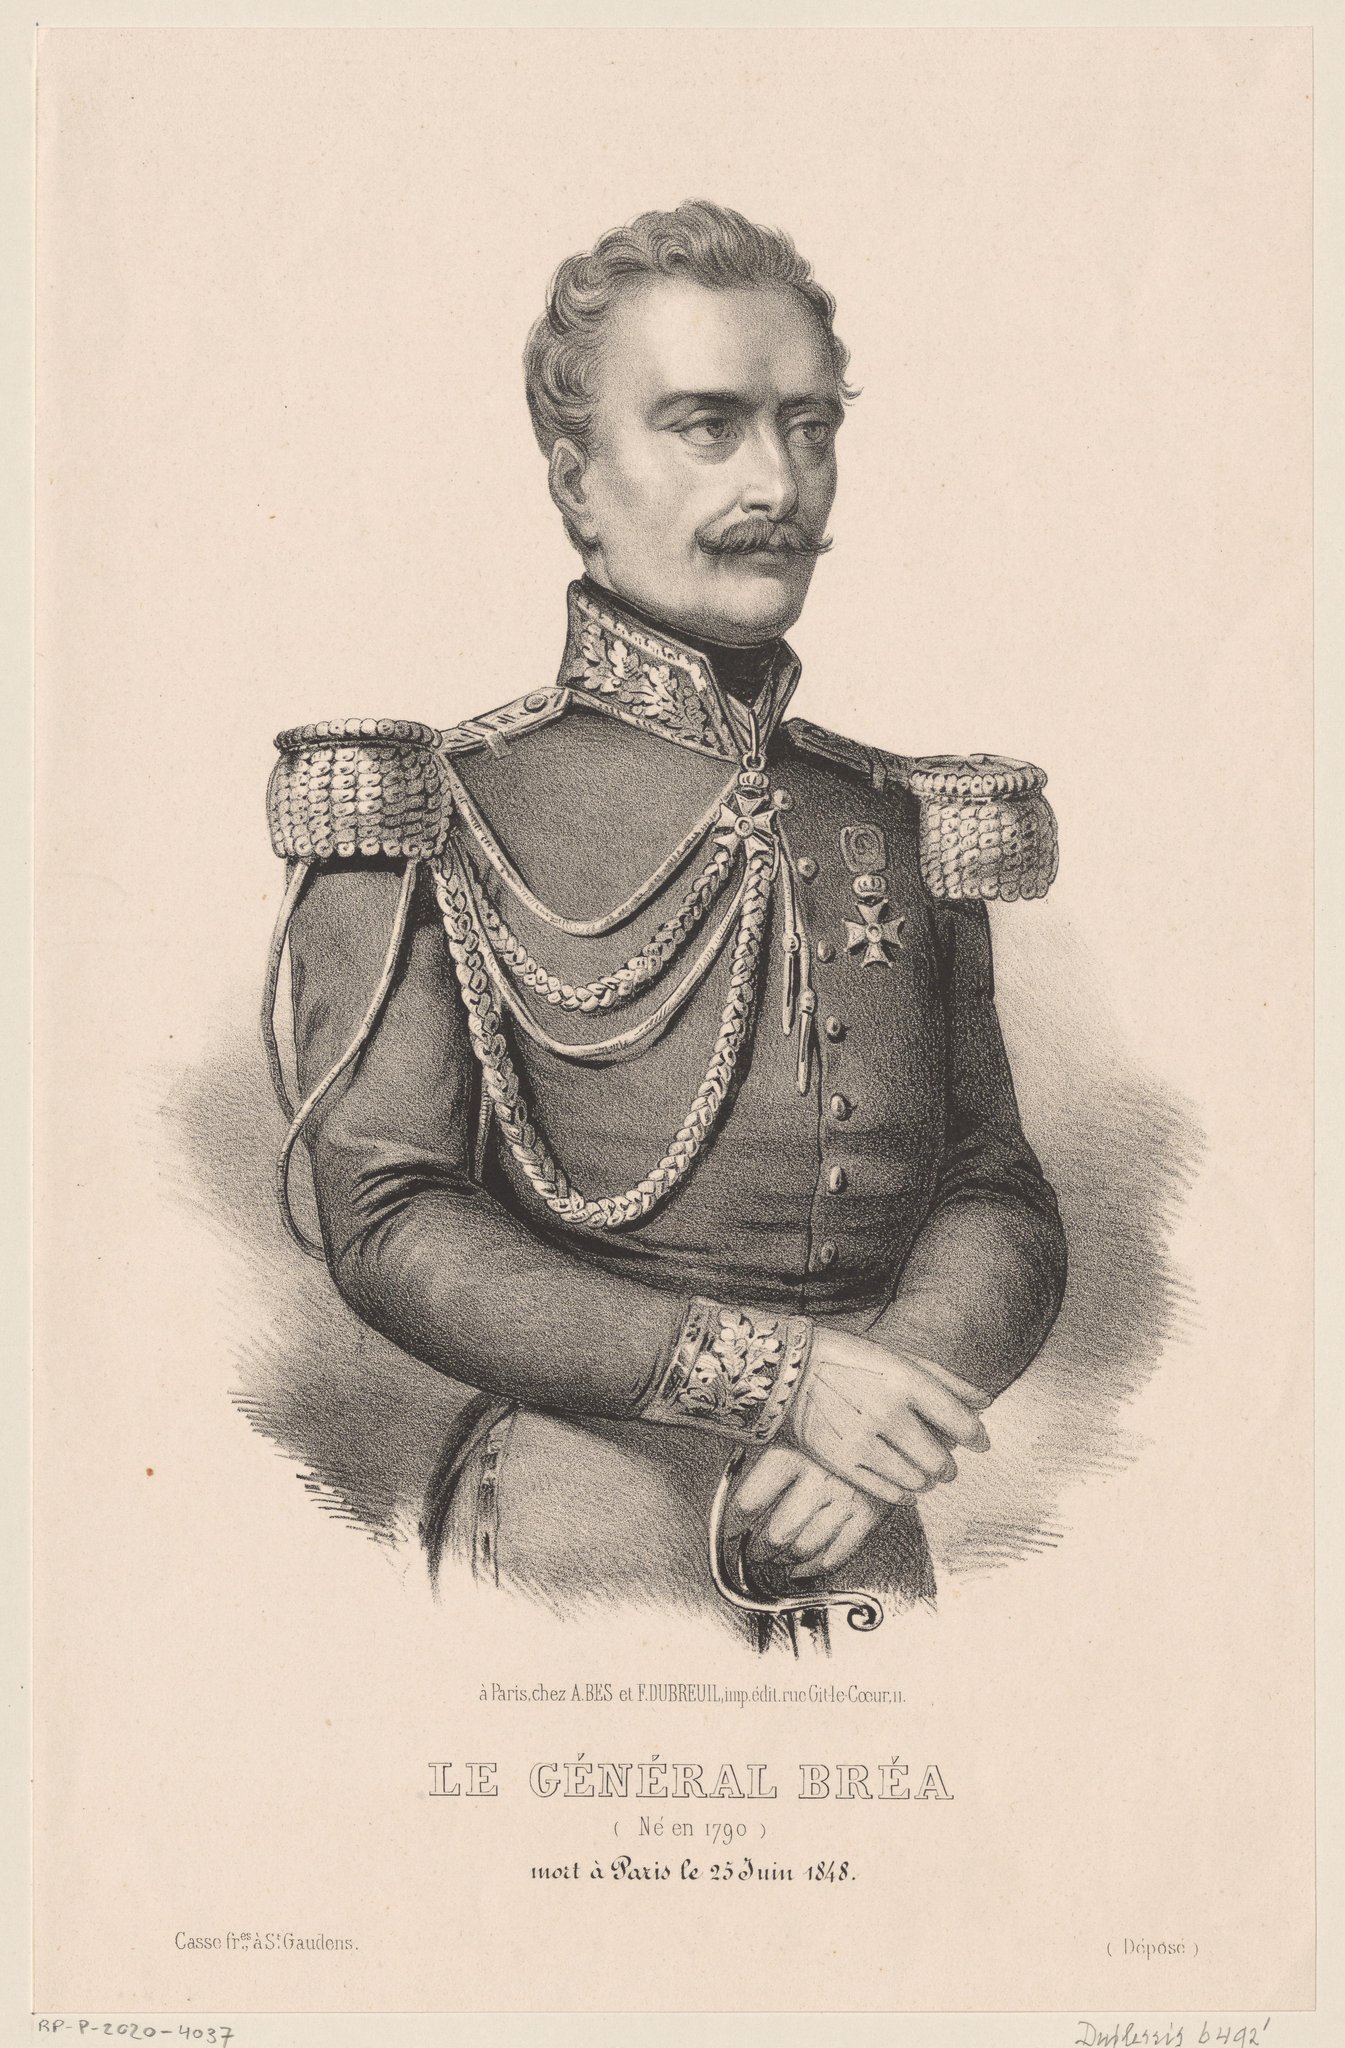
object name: print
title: Portret van Jean Baptiste Fidèle Bréa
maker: Anonymous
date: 1848-1854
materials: paper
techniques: lithograph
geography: saint-gaudens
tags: commander-in-chief, general, marshal, historical persons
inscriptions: : ‘Déposé’